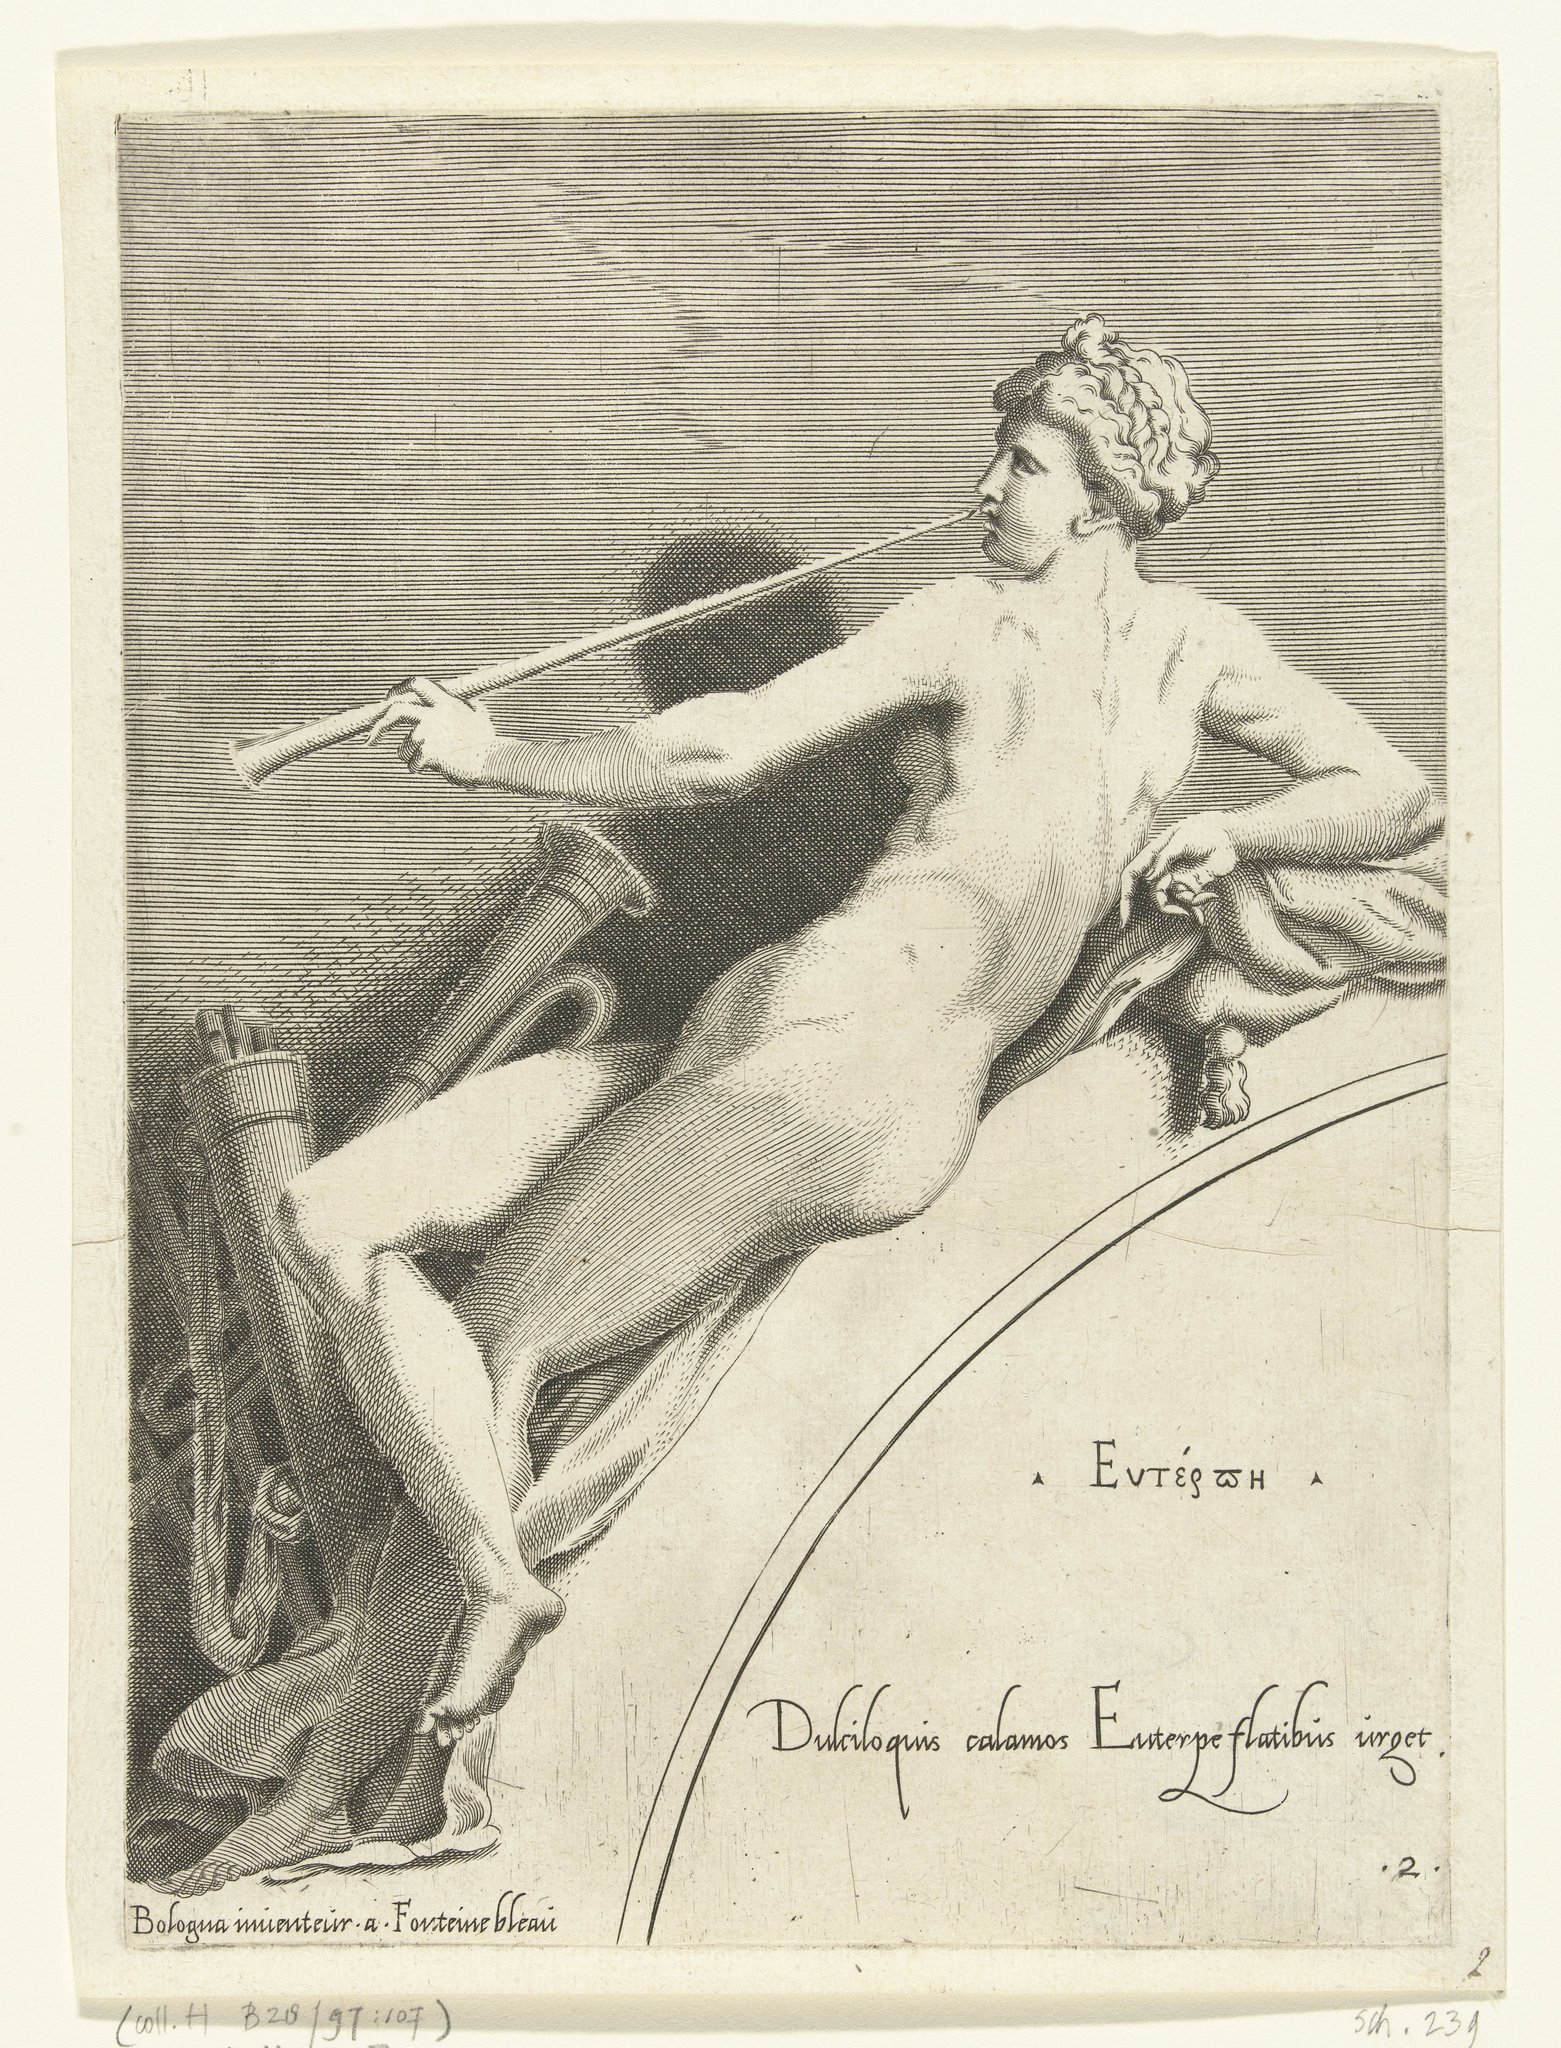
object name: print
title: Euterpe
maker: cornelis bos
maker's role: print maker, printer, publisher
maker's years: 1510-1566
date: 1540-1555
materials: paper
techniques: engraving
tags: euterpe (one of the muses); 'euterpe' (ripa)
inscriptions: collector's mark: Lugt 11, collector's mark: Lugt 2228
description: De muze Euterpe leunend op een boog. Ze blaast op een bazuin. Haar naam in het Grieks en een verwijzing in het Latijn staan op de boog.